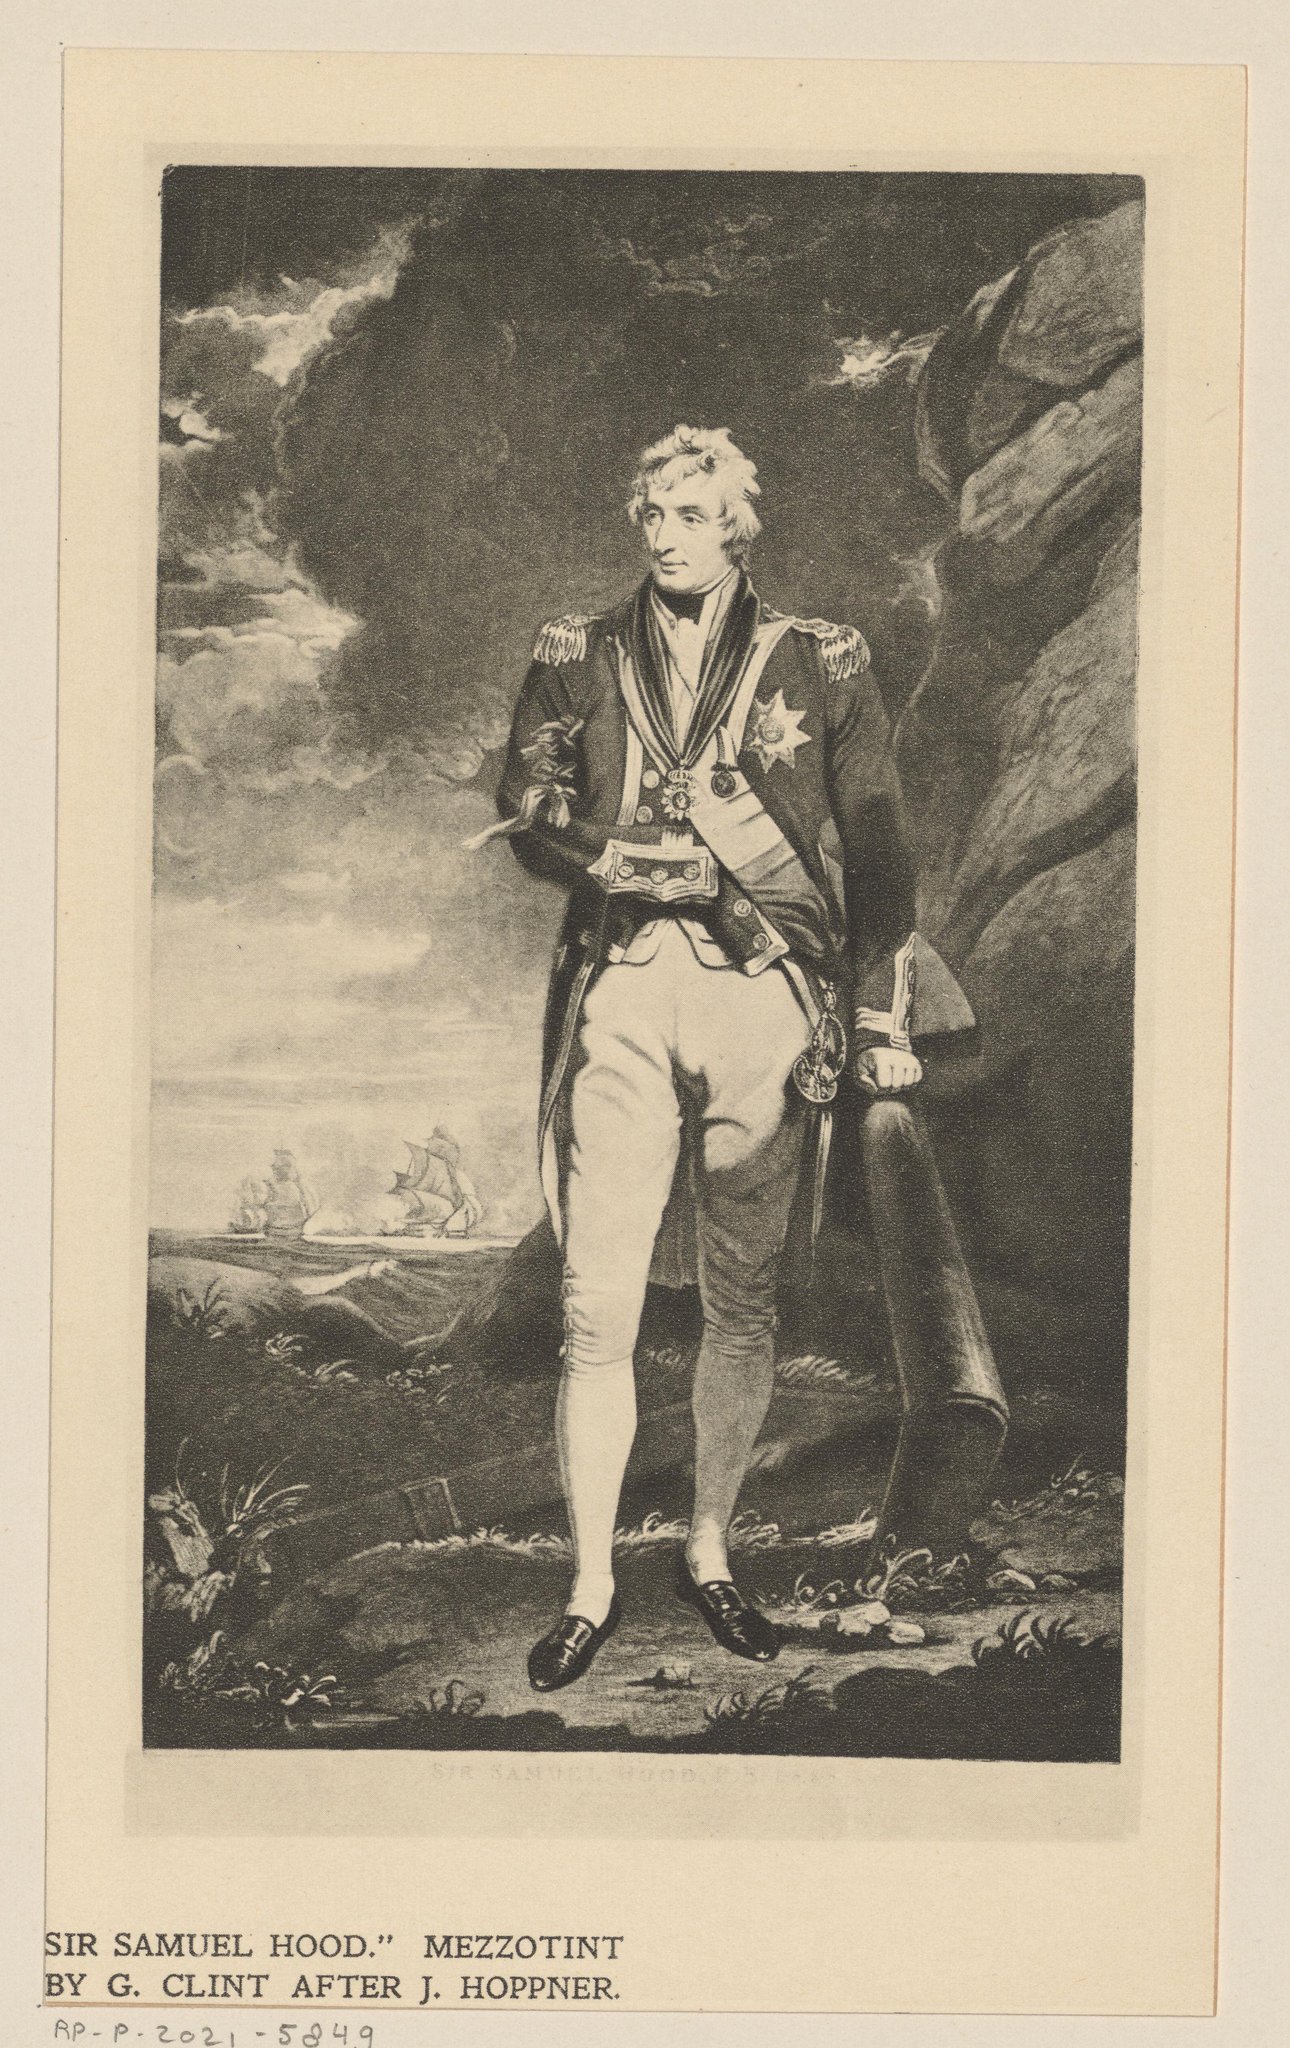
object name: photomechanical print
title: Portret van Samuel Hood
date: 1890-1930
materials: paper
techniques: rotogravure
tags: historical persons, commander-in-chief, admiral